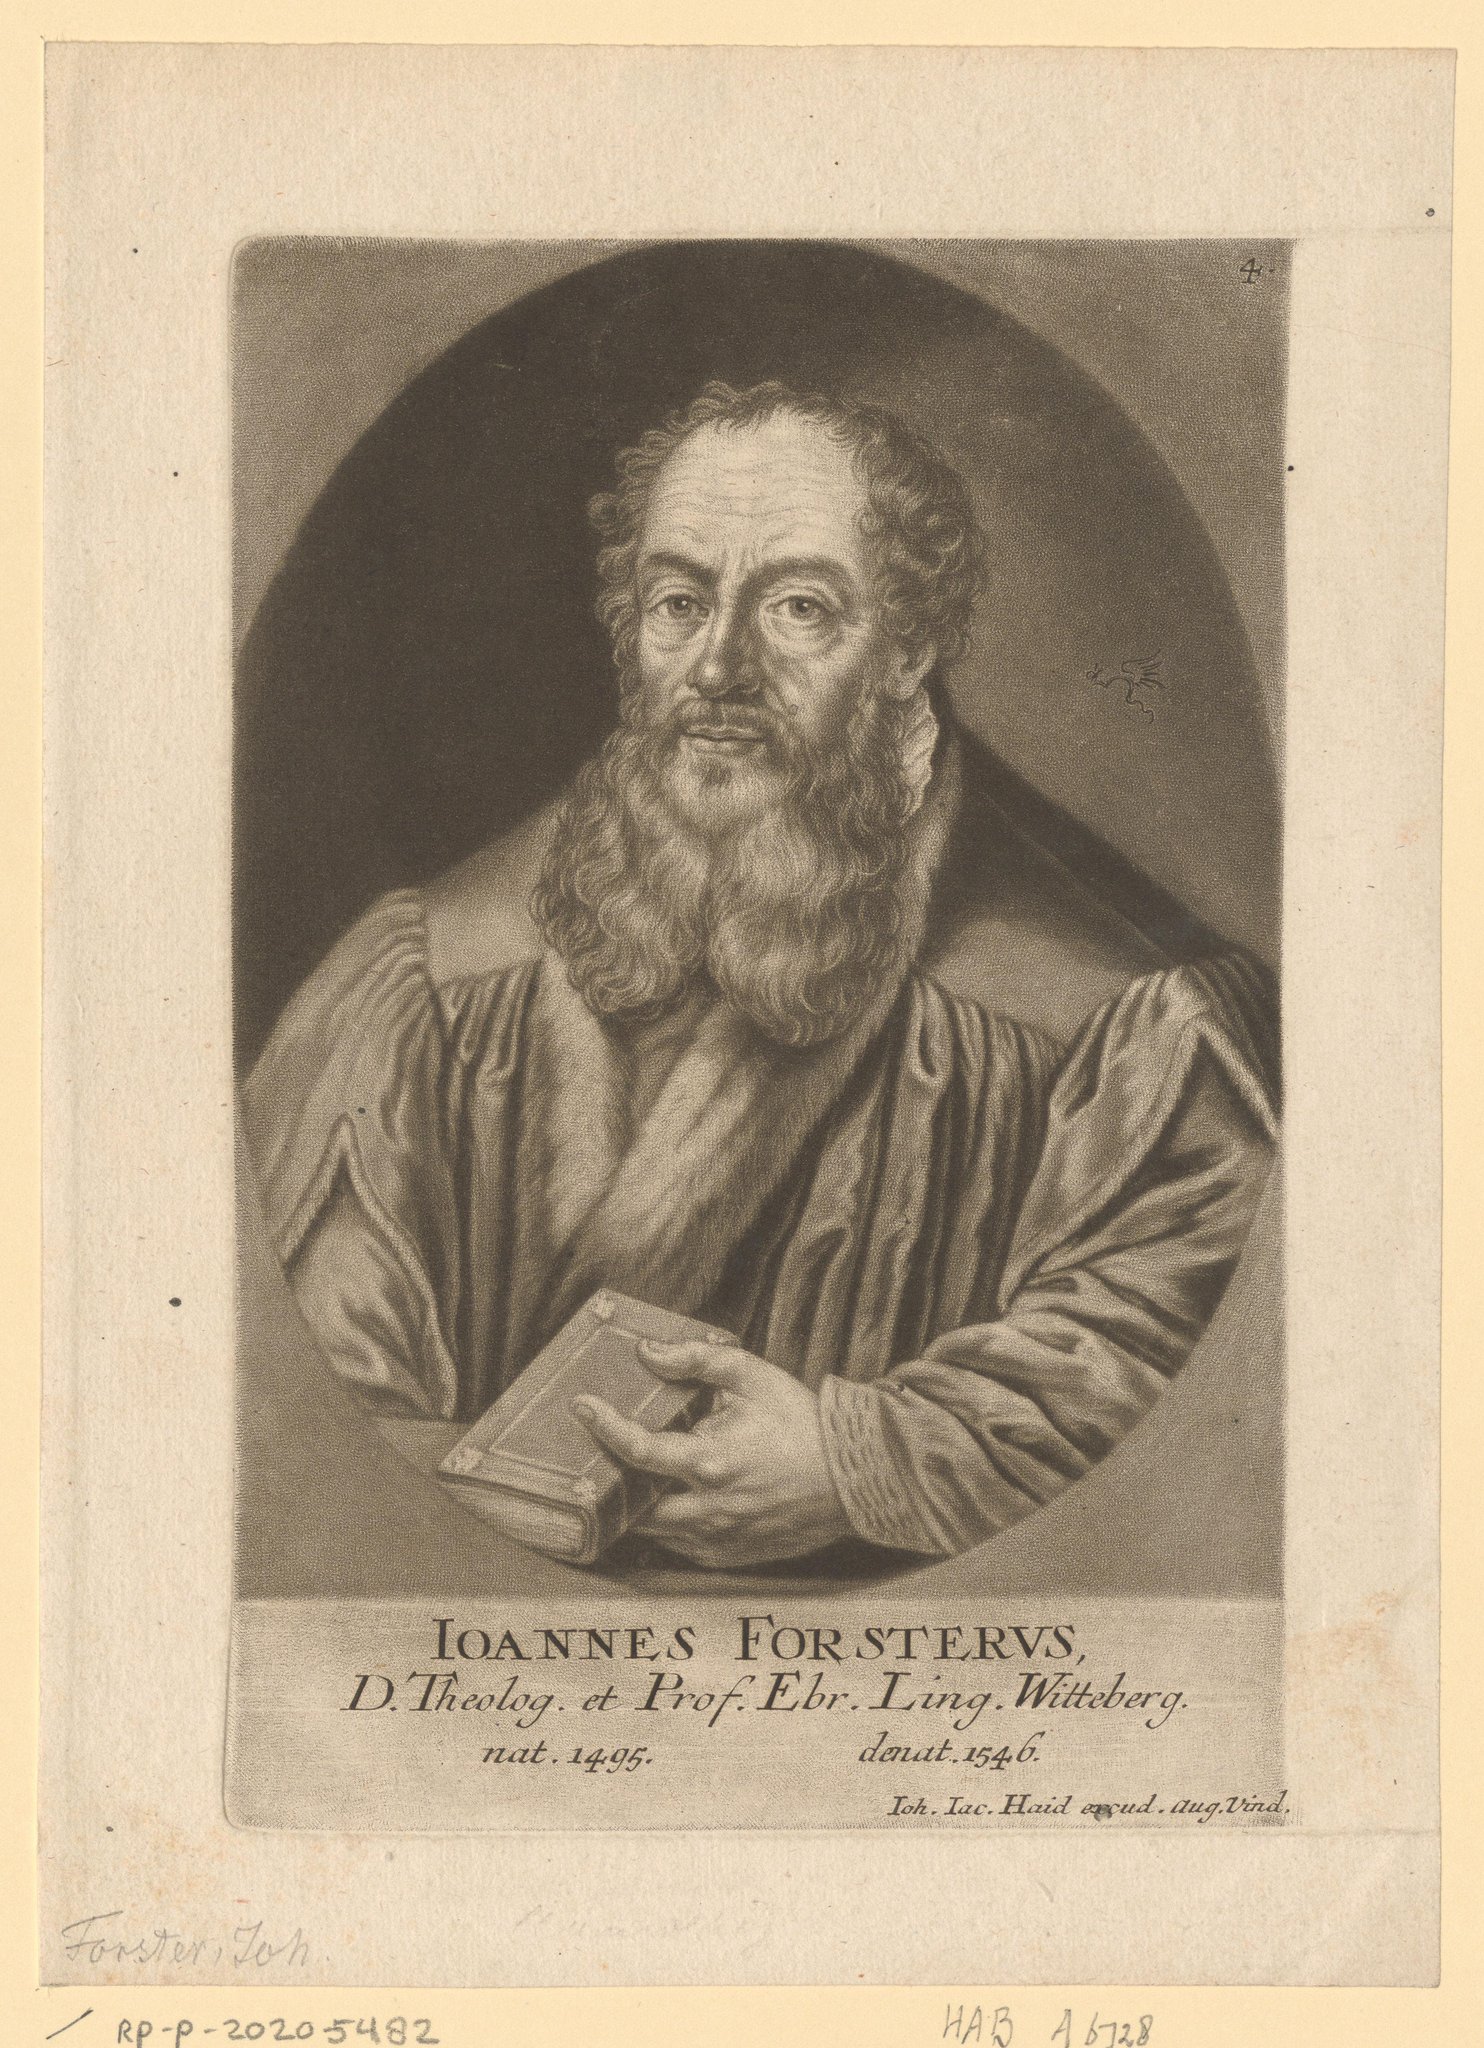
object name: print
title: Portret van Johann Forster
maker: johann jacob haid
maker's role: print maker, publisher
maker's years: 1704-1767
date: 1747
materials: paper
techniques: mezzotint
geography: augsburg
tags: augsburg, theologian, historical persons, book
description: Prent waarschijnlijk uit: Brucker, Jacob. Ehrentempel der Deutschen Gelehrsamkeit. Augsburg: Johann Jacob Haid, 1747.